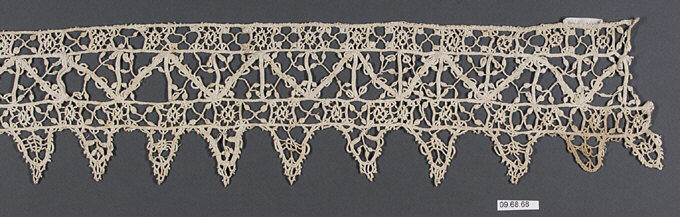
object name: piece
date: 1600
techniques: lace